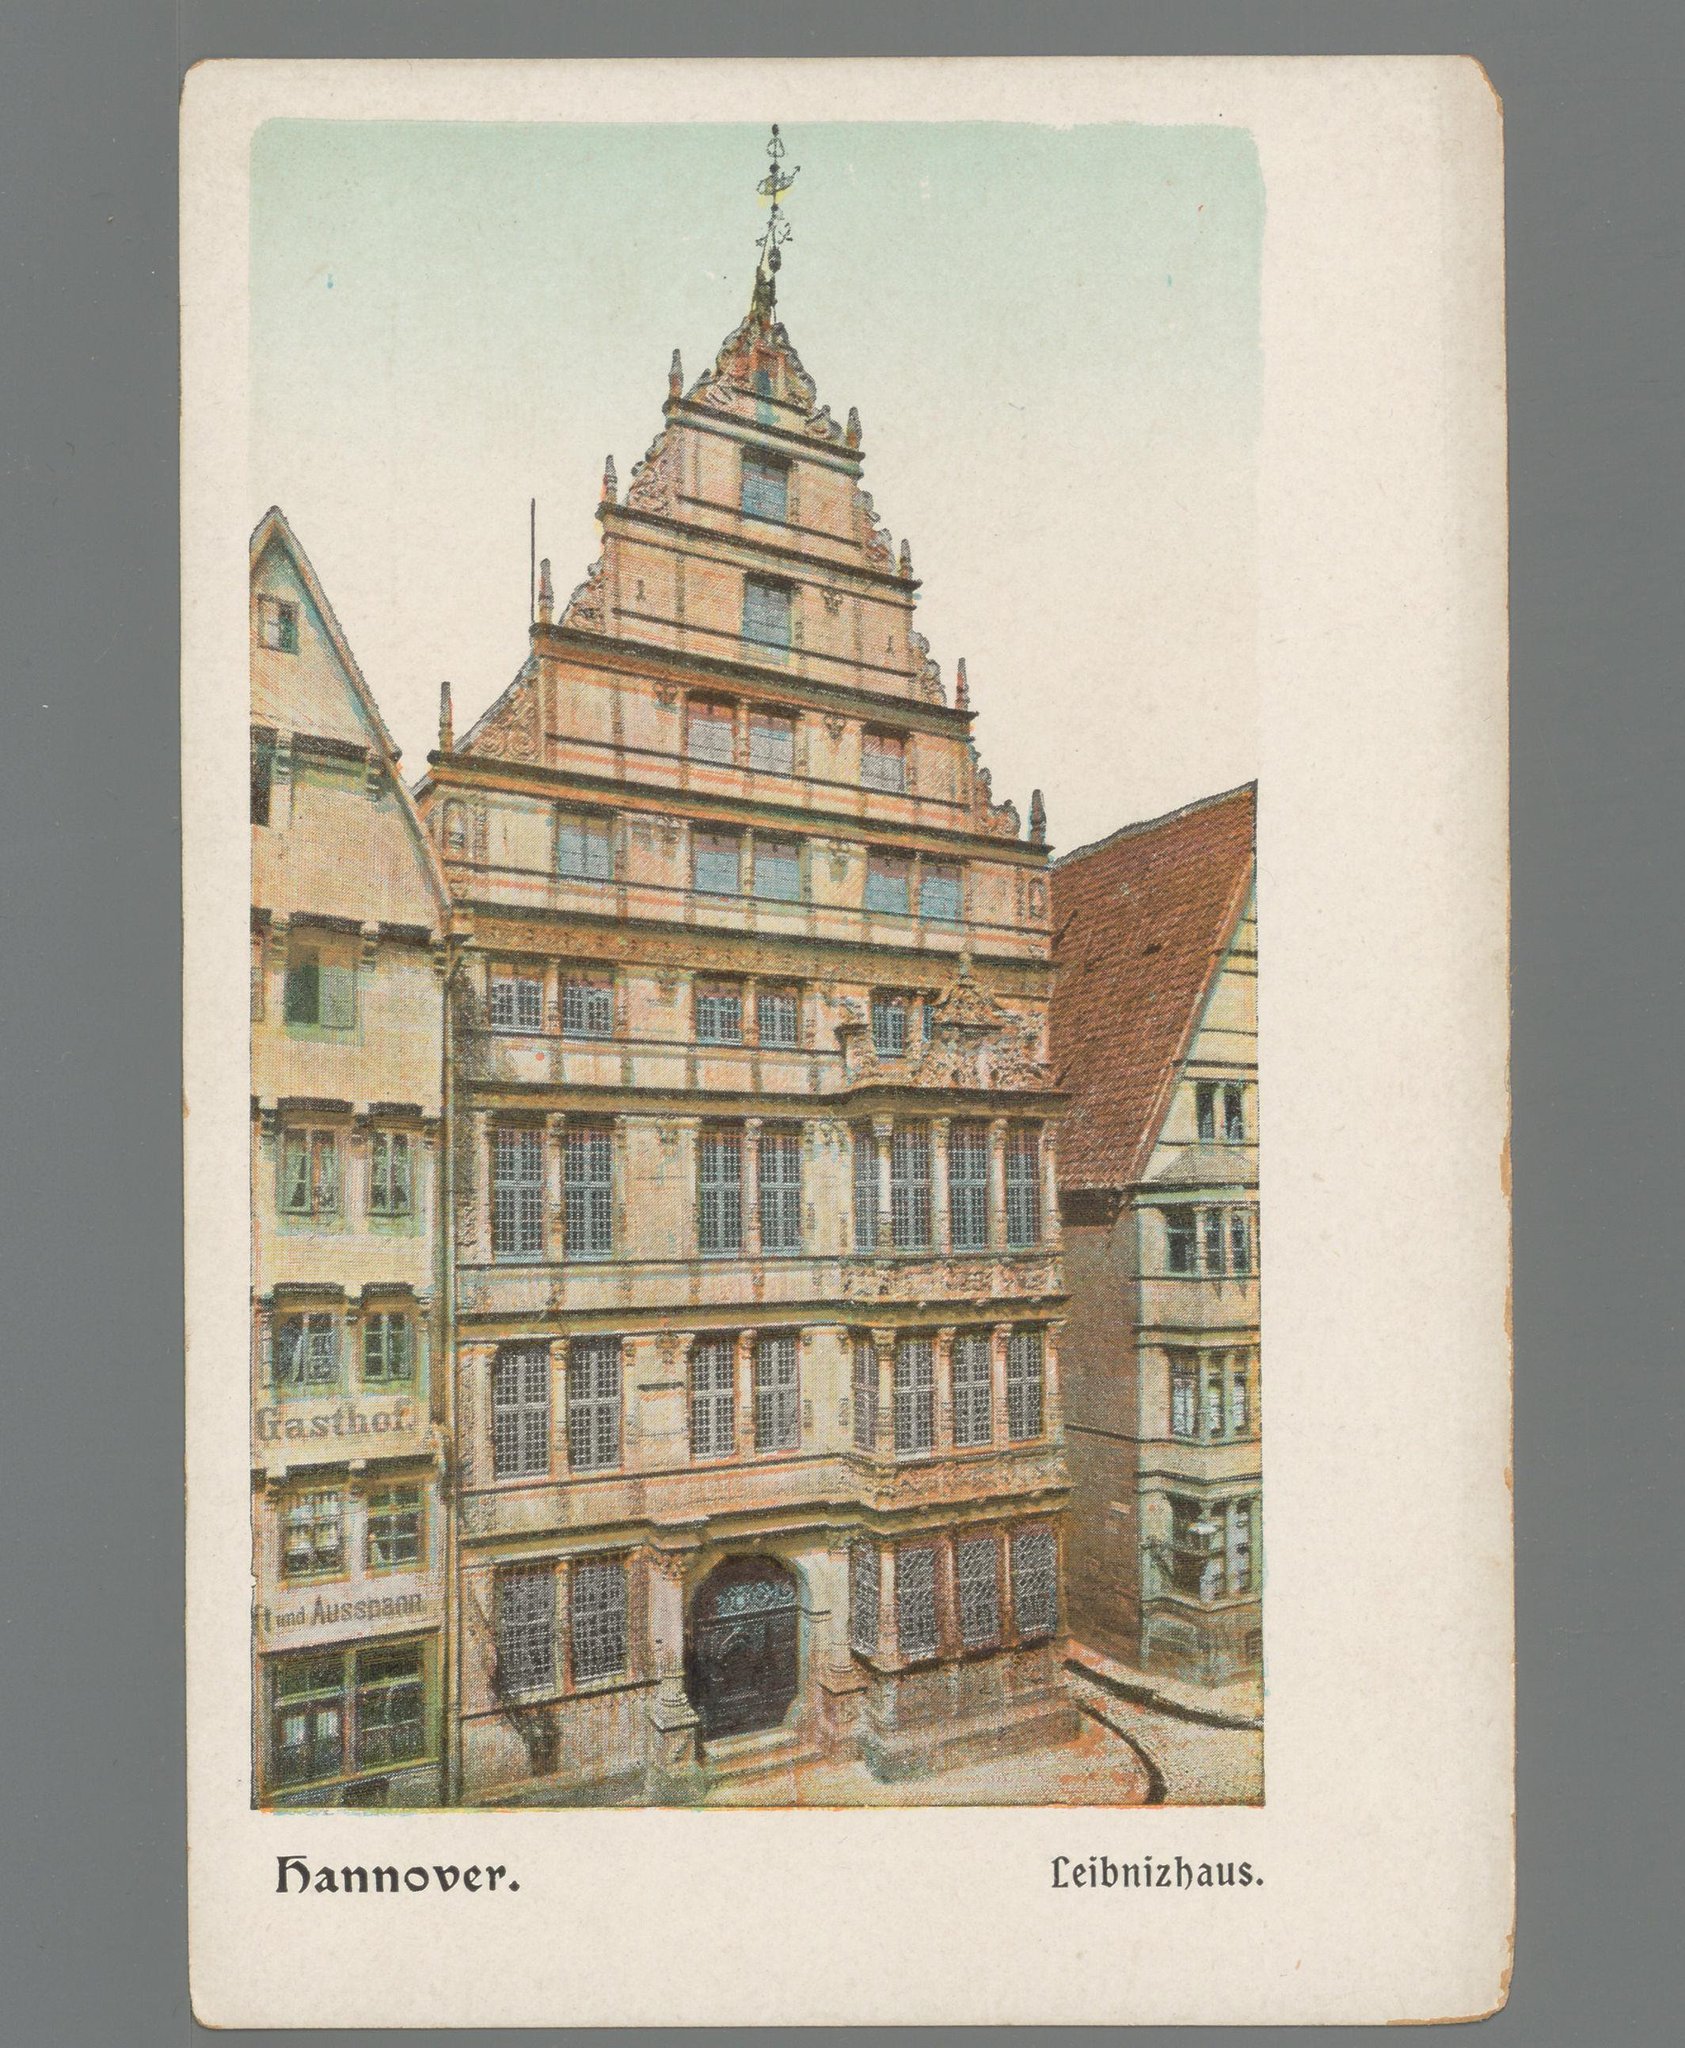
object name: photomechanical print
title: Hannover. Leibnizhaus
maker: Anonymous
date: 1885-1905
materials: cardboard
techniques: lithograph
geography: hannover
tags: façade (of house or building)